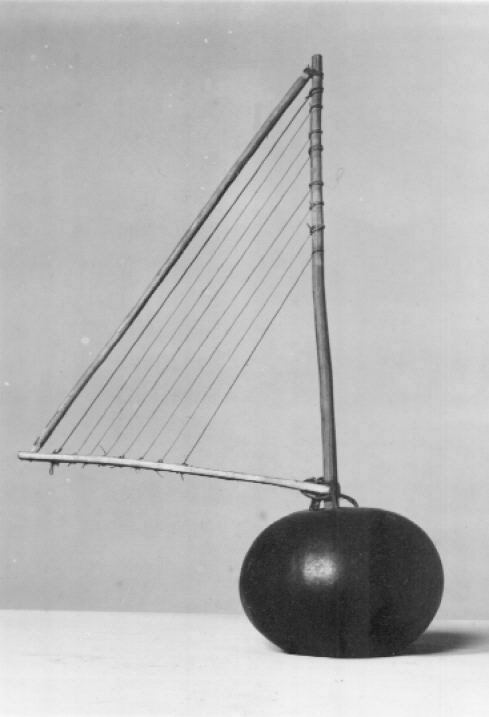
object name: oba or kani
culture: kru or limba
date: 1867-1900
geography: sierra leone